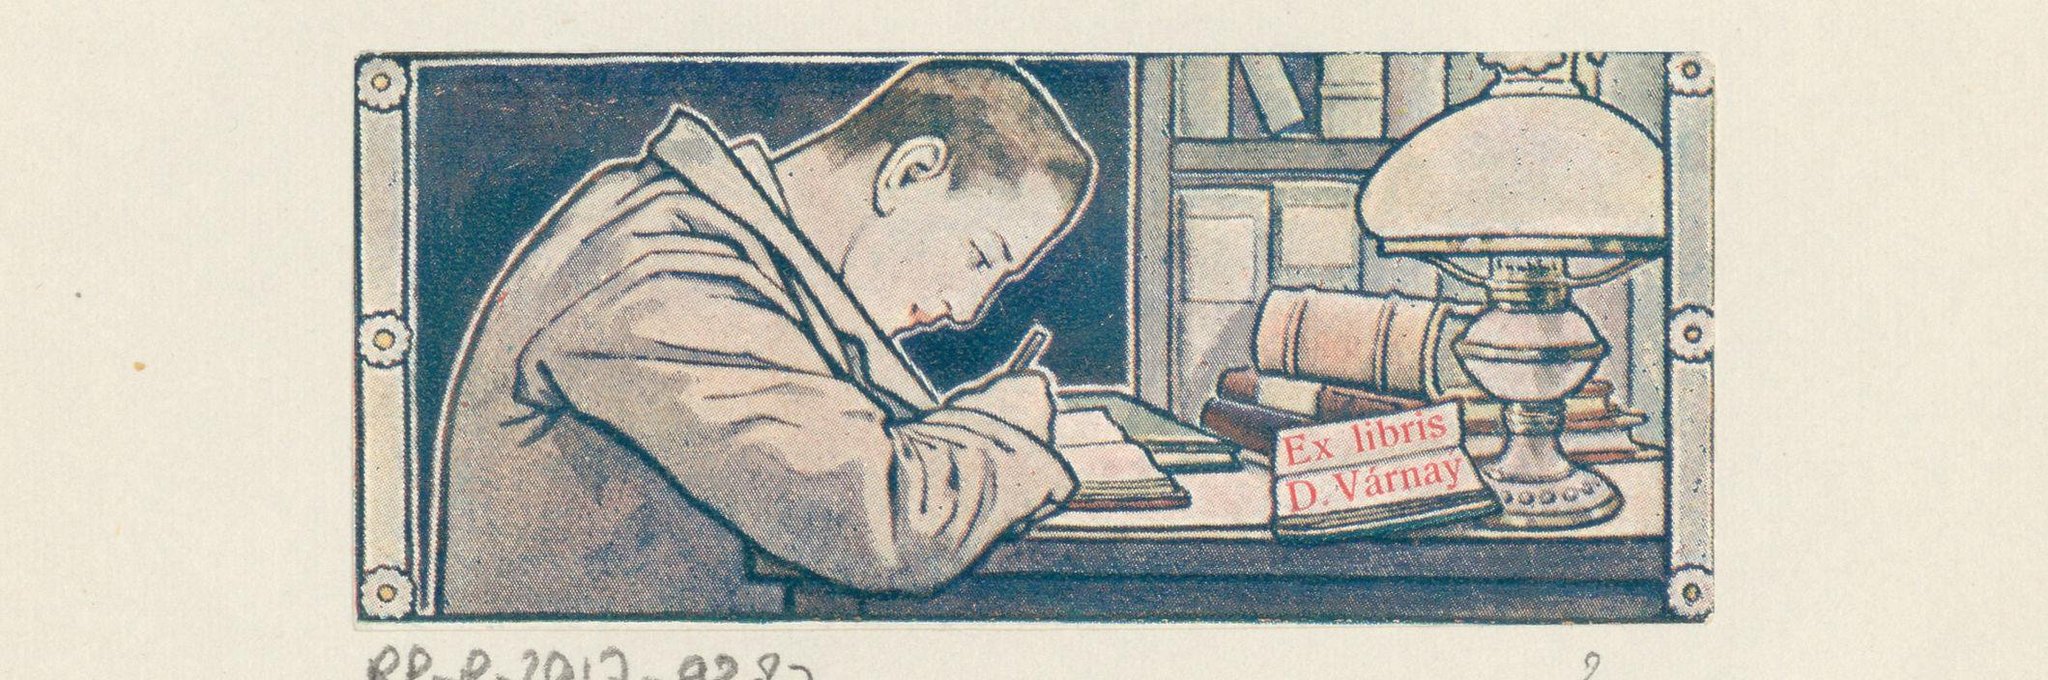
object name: photomechanical print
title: Ex libris van D. Várnay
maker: Anonymous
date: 1880-1939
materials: paper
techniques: autotype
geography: czech republic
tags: standing figure, gas-lamp, book